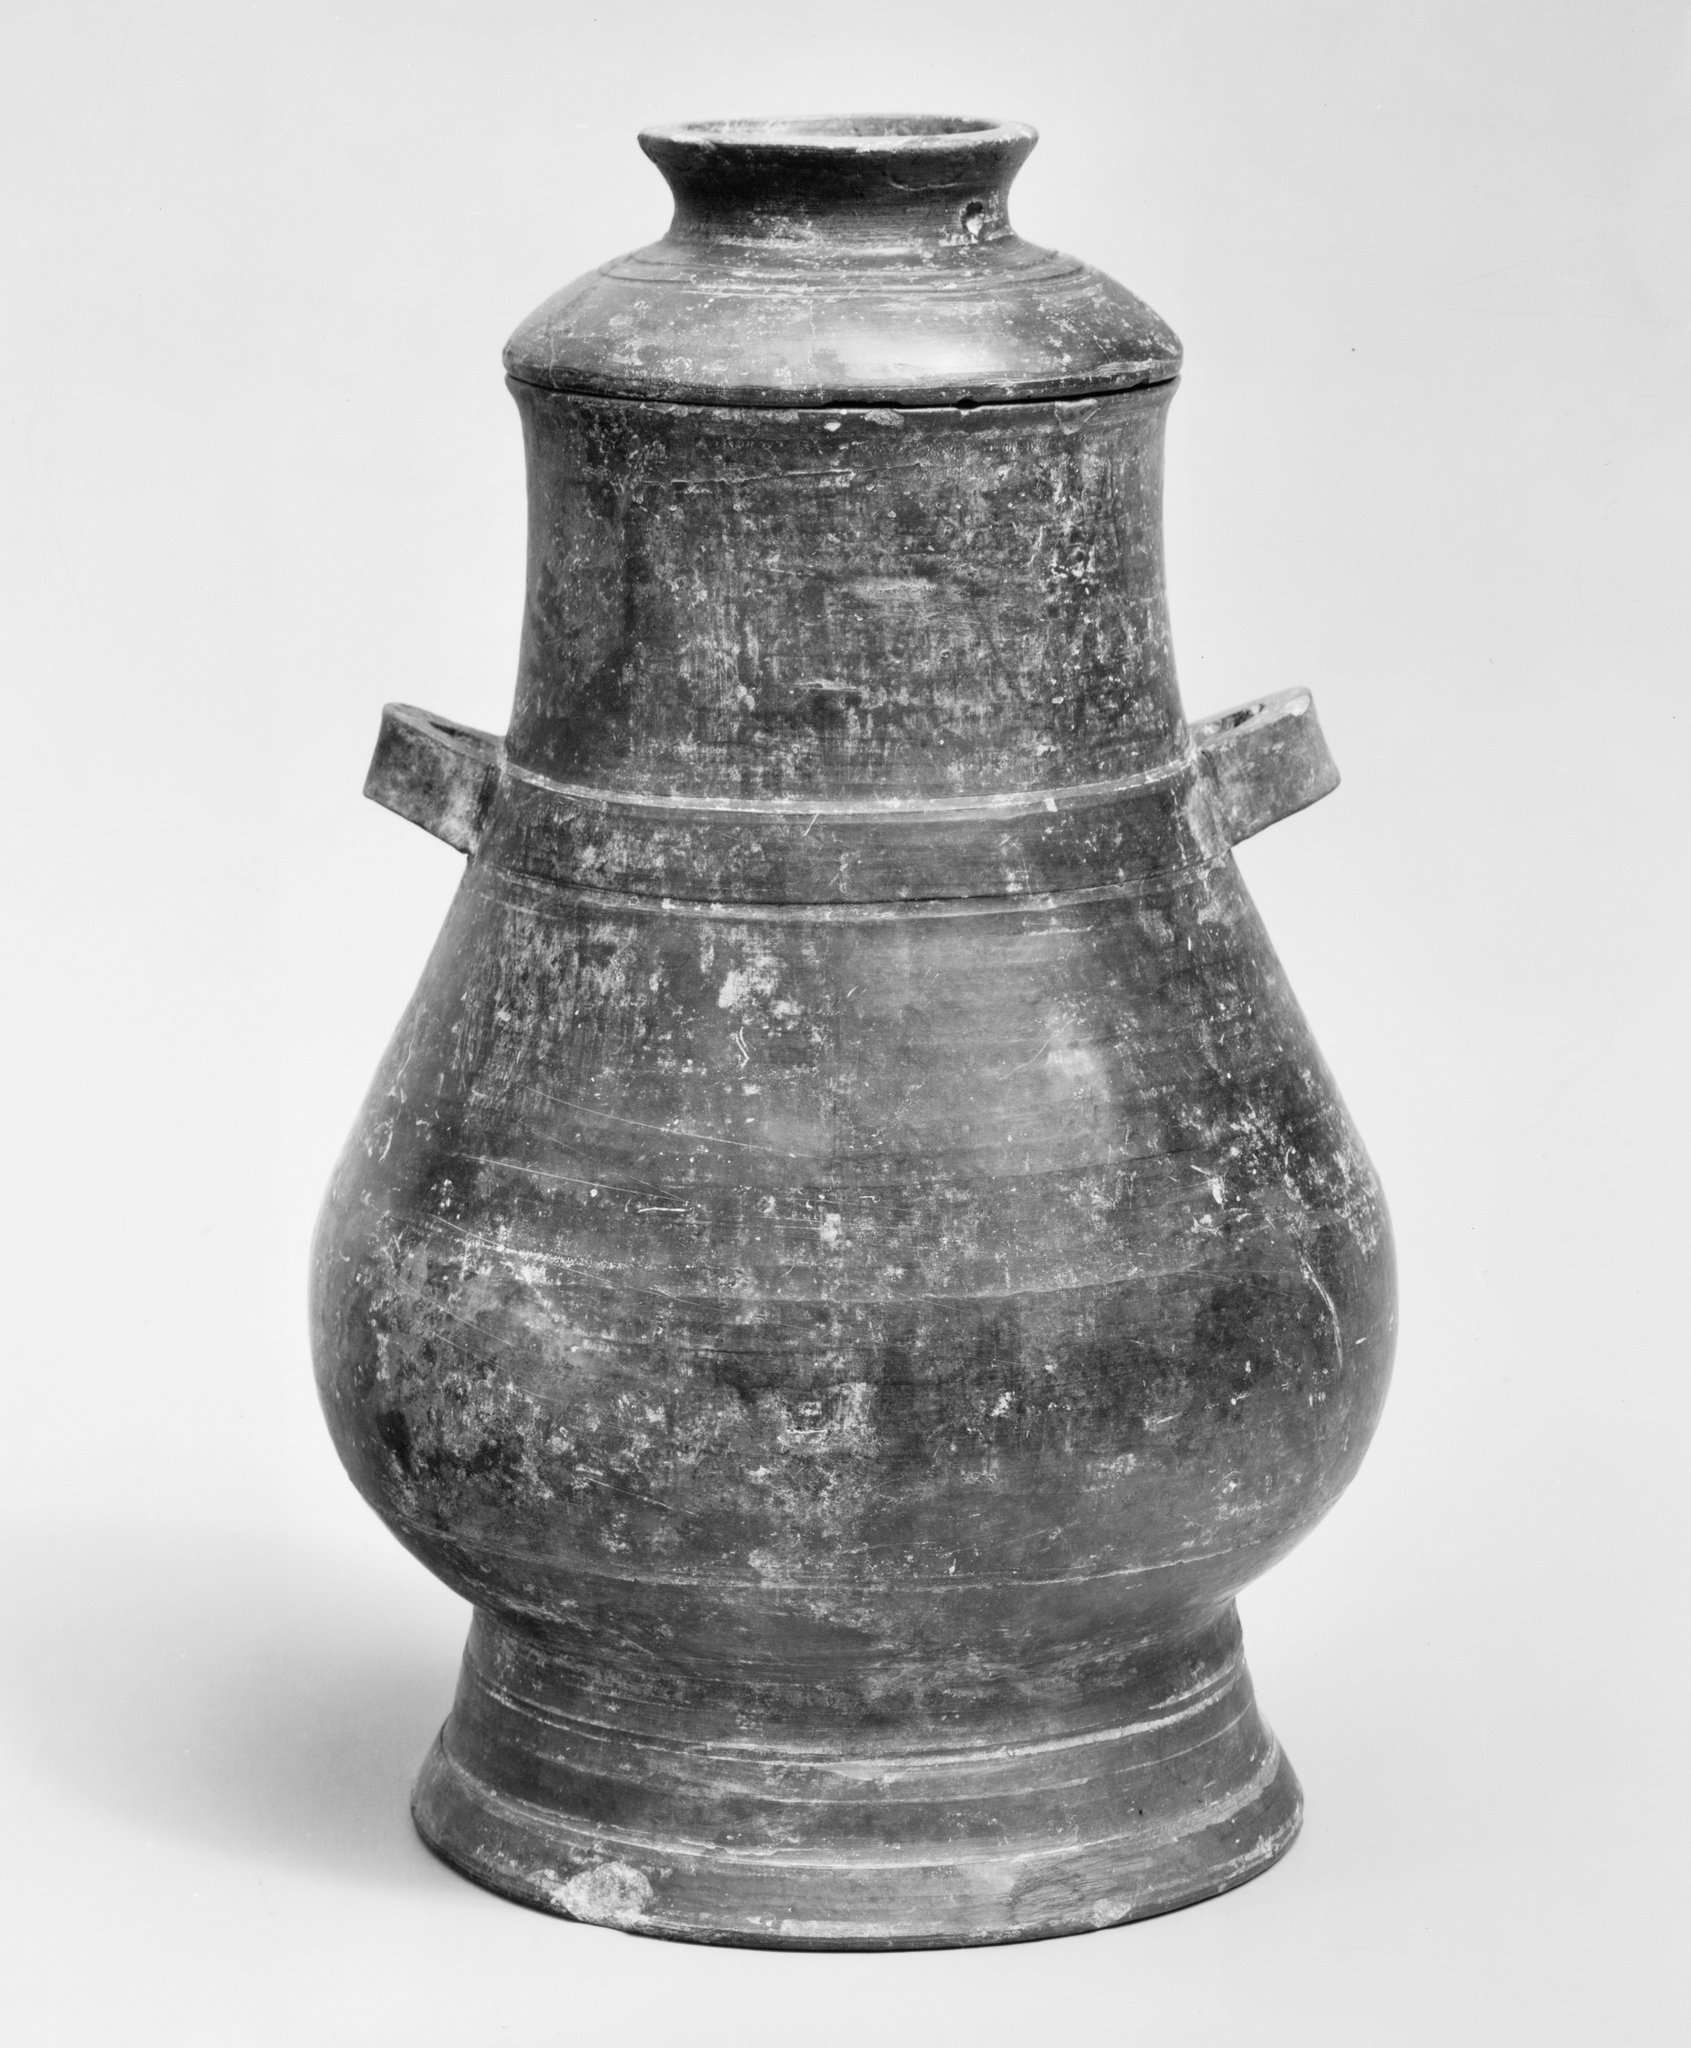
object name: vase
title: Vase (Hu)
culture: chinese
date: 2400-2000 BCE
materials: earthenware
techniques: burnishing